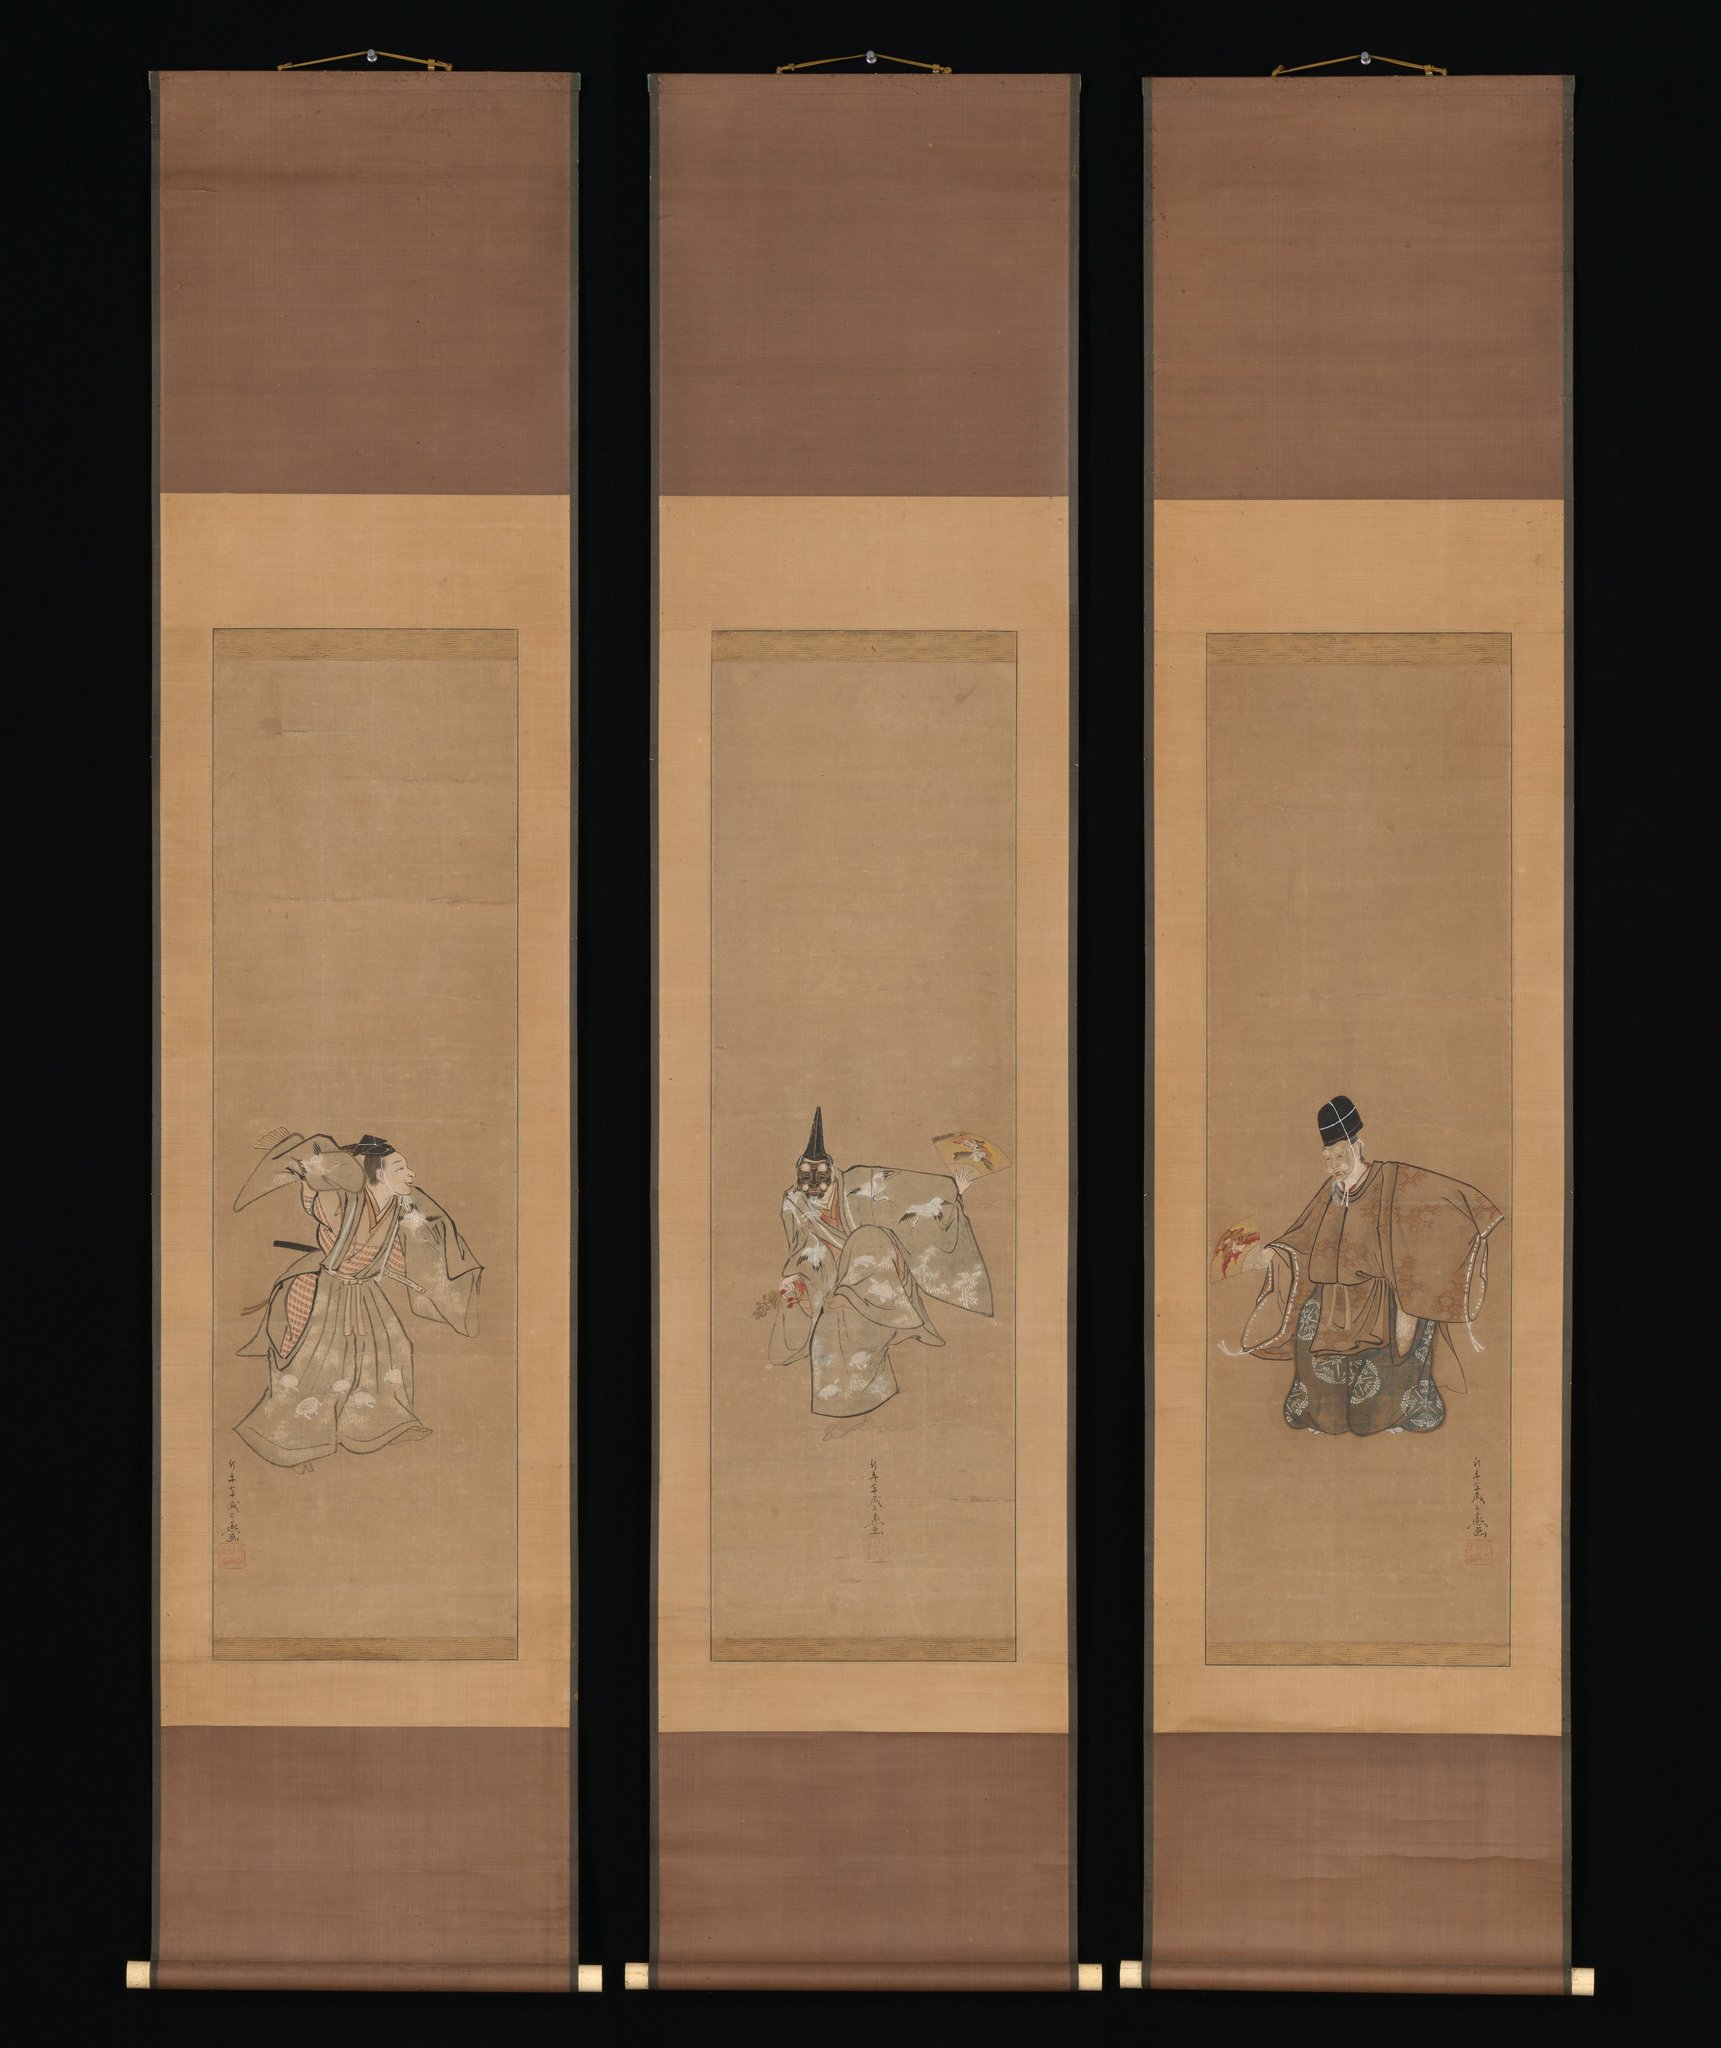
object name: hanging scroll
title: The Auspicious Noh Dance "Okina"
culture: japanese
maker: toriyama sekien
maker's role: artist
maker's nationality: japanese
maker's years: 1712-1788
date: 1790-1795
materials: gold, ink, paper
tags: men,dancing,dancers